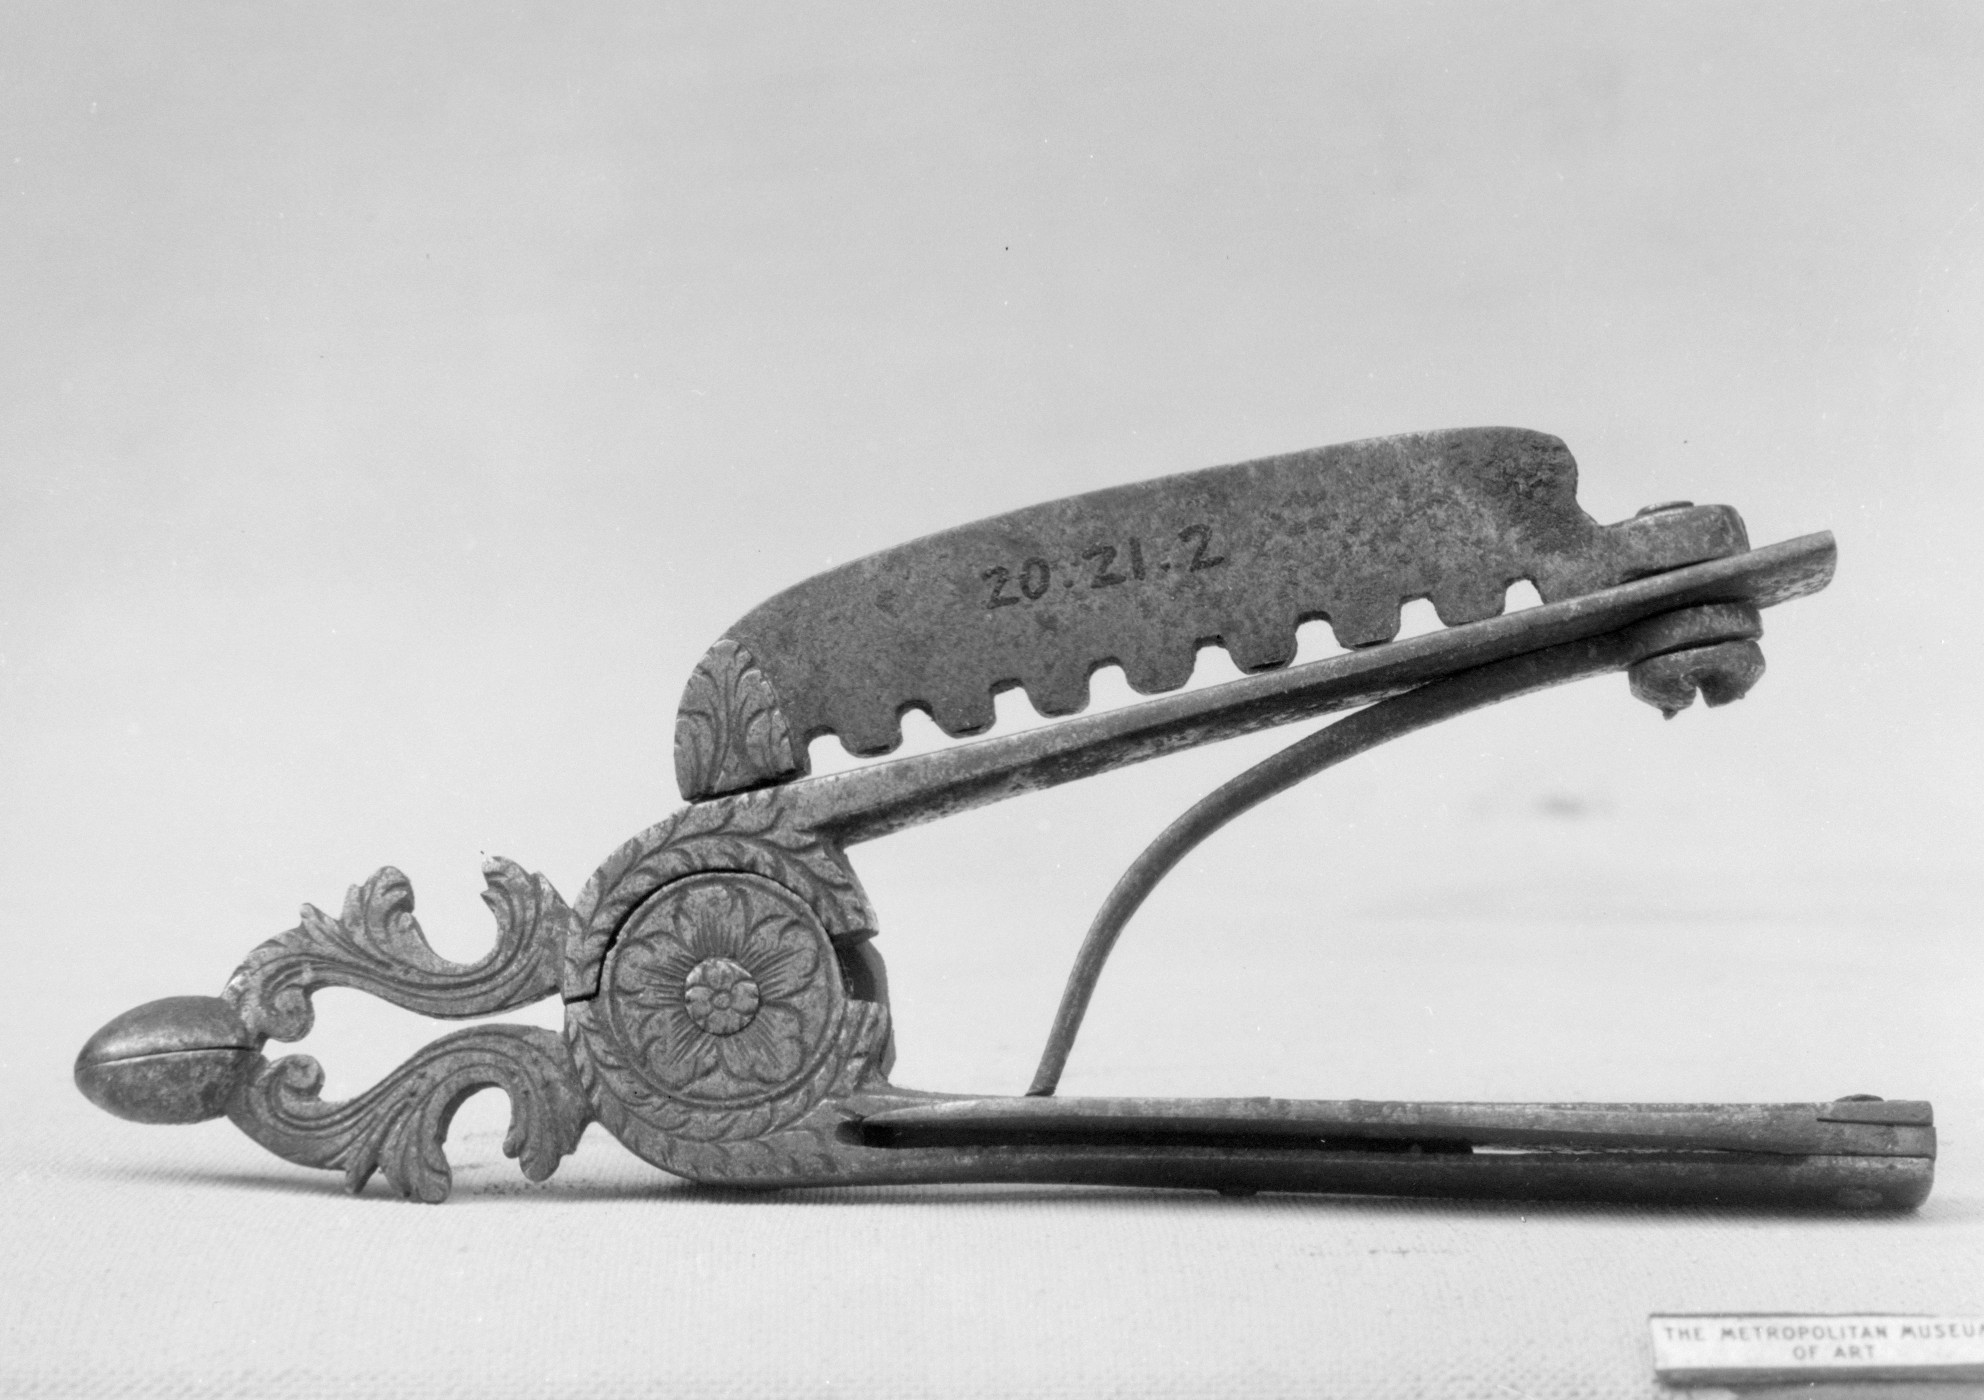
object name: smoker's companion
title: Smoker's companion (?)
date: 1601-1700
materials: steel